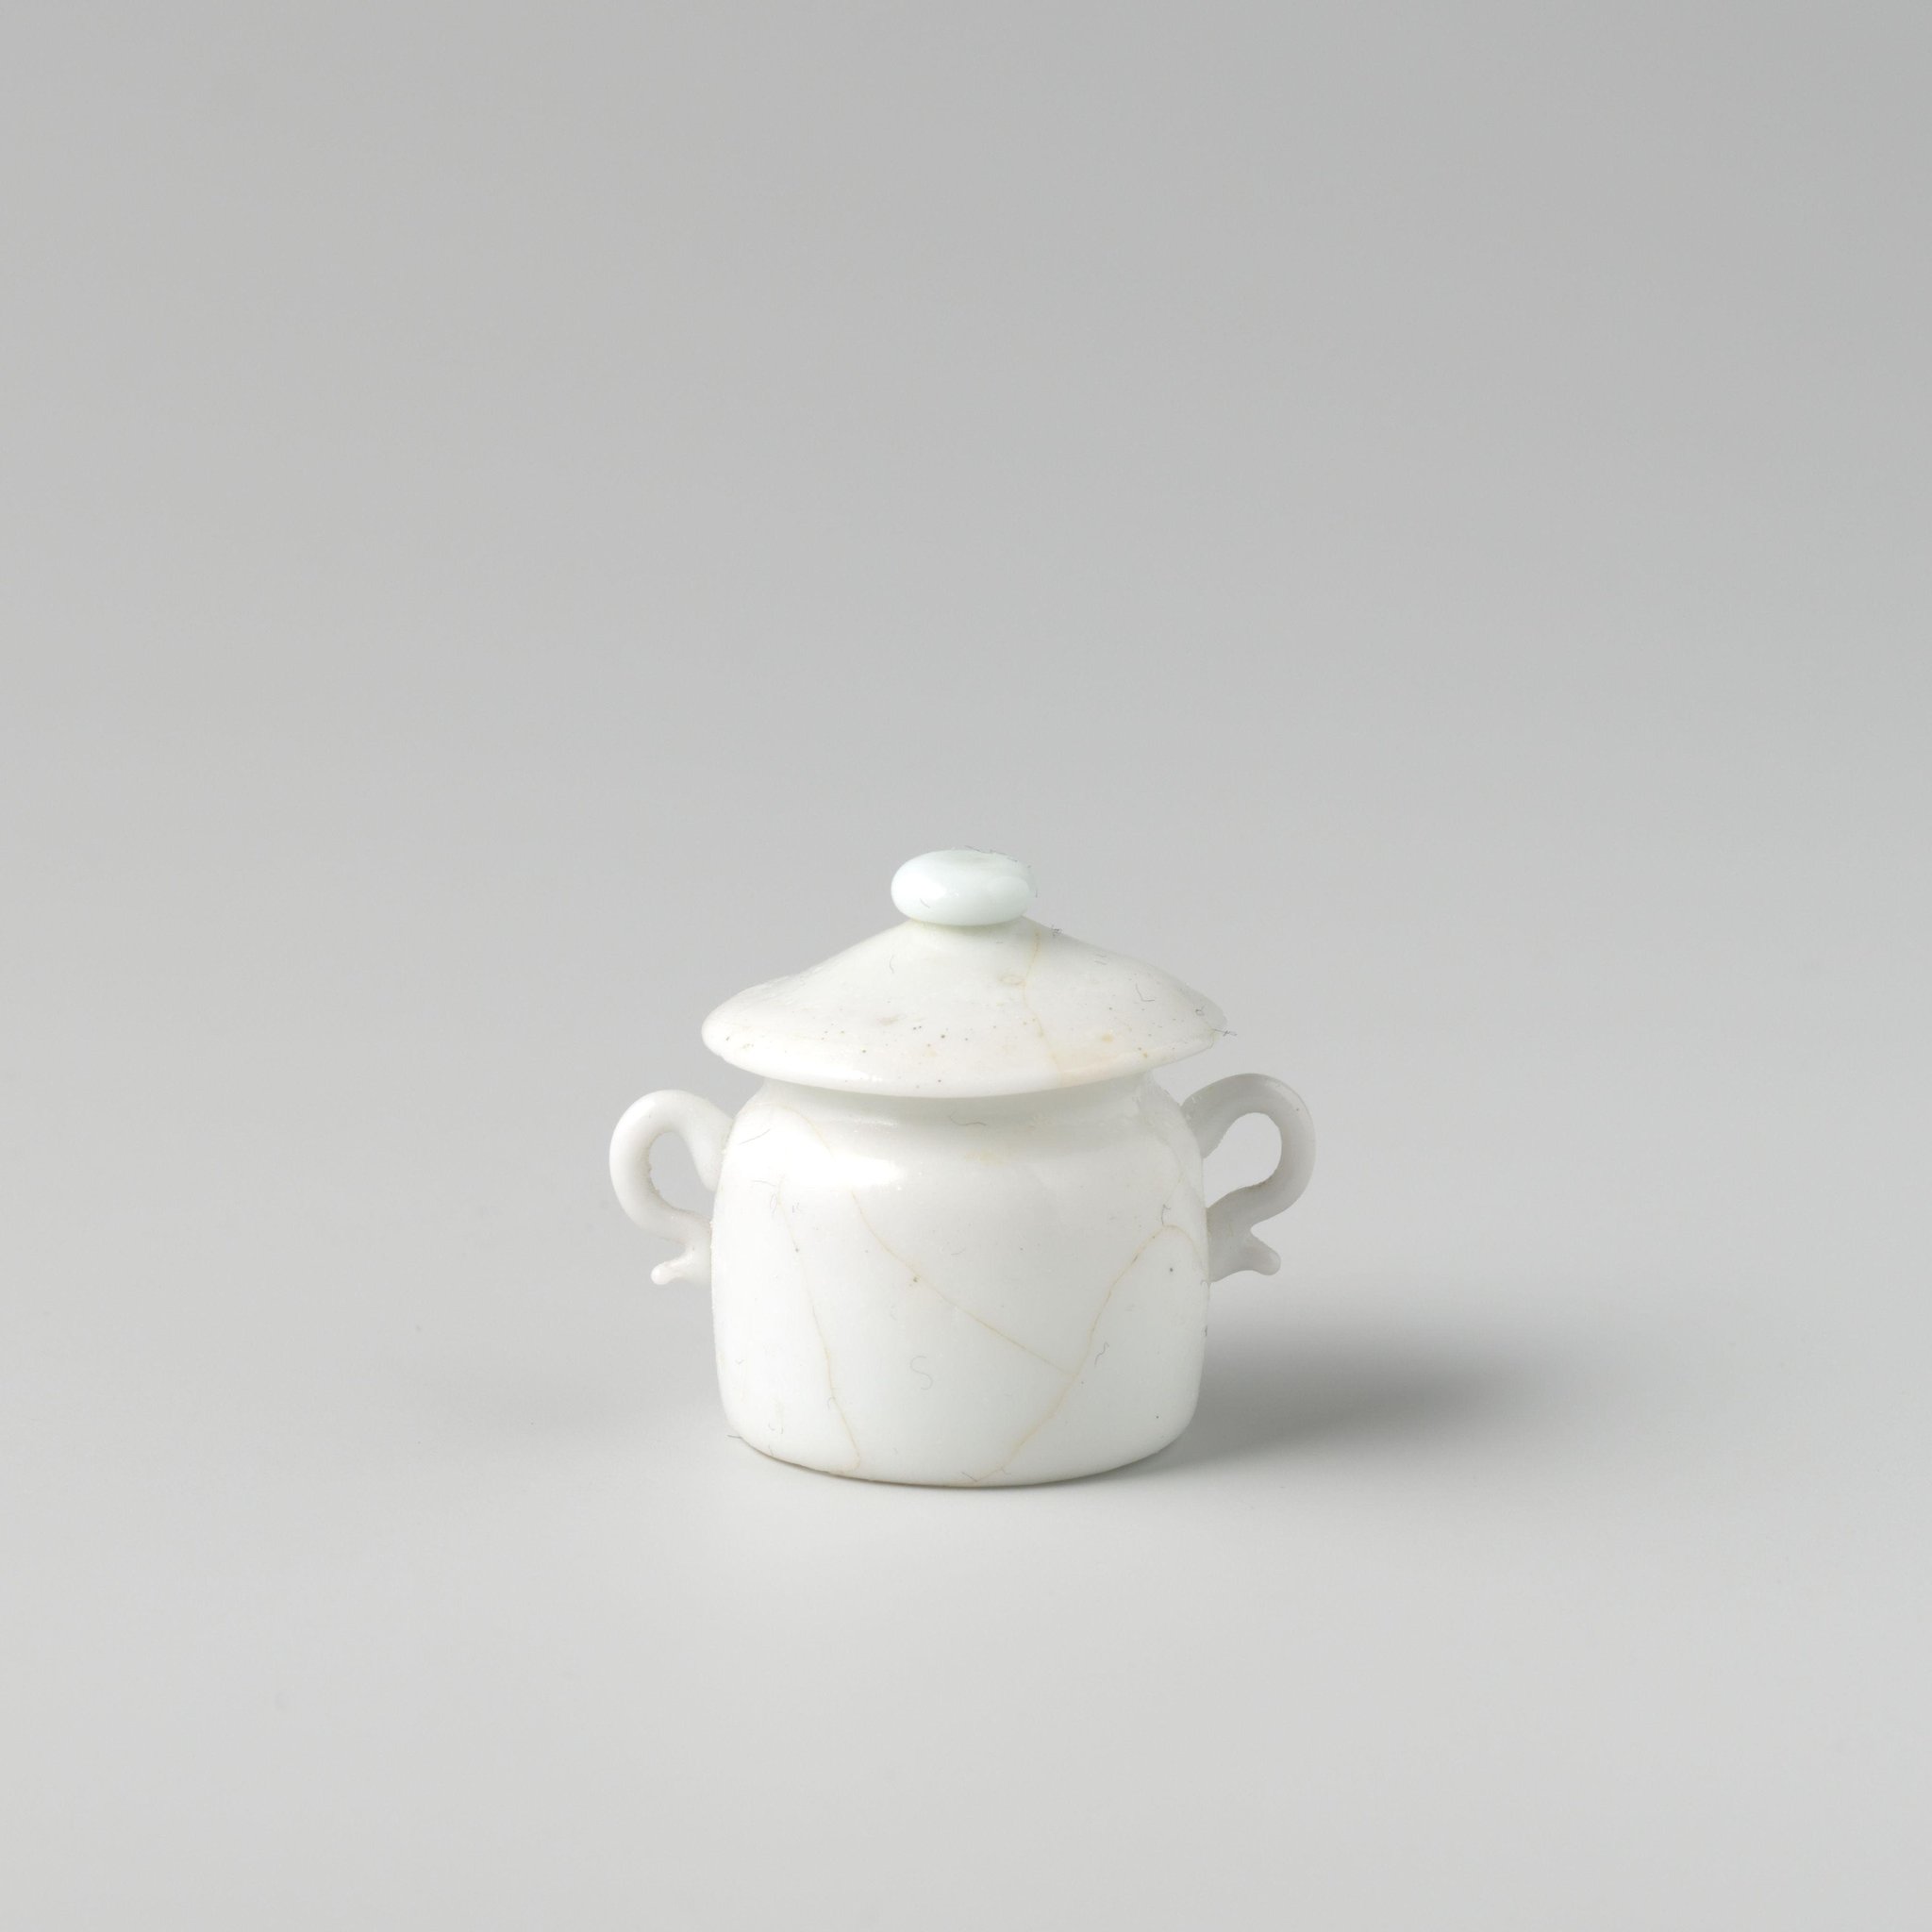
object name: covered jar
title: Dekselpot van opaak wit glas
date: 1690-1700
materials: glass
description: Dekselpot van opaak wit glas, cilindrische model met naar binnen gestoken bodem en twee aangezette oren, deksels dubbelwandig en verschillend van vorm met knop of oor.